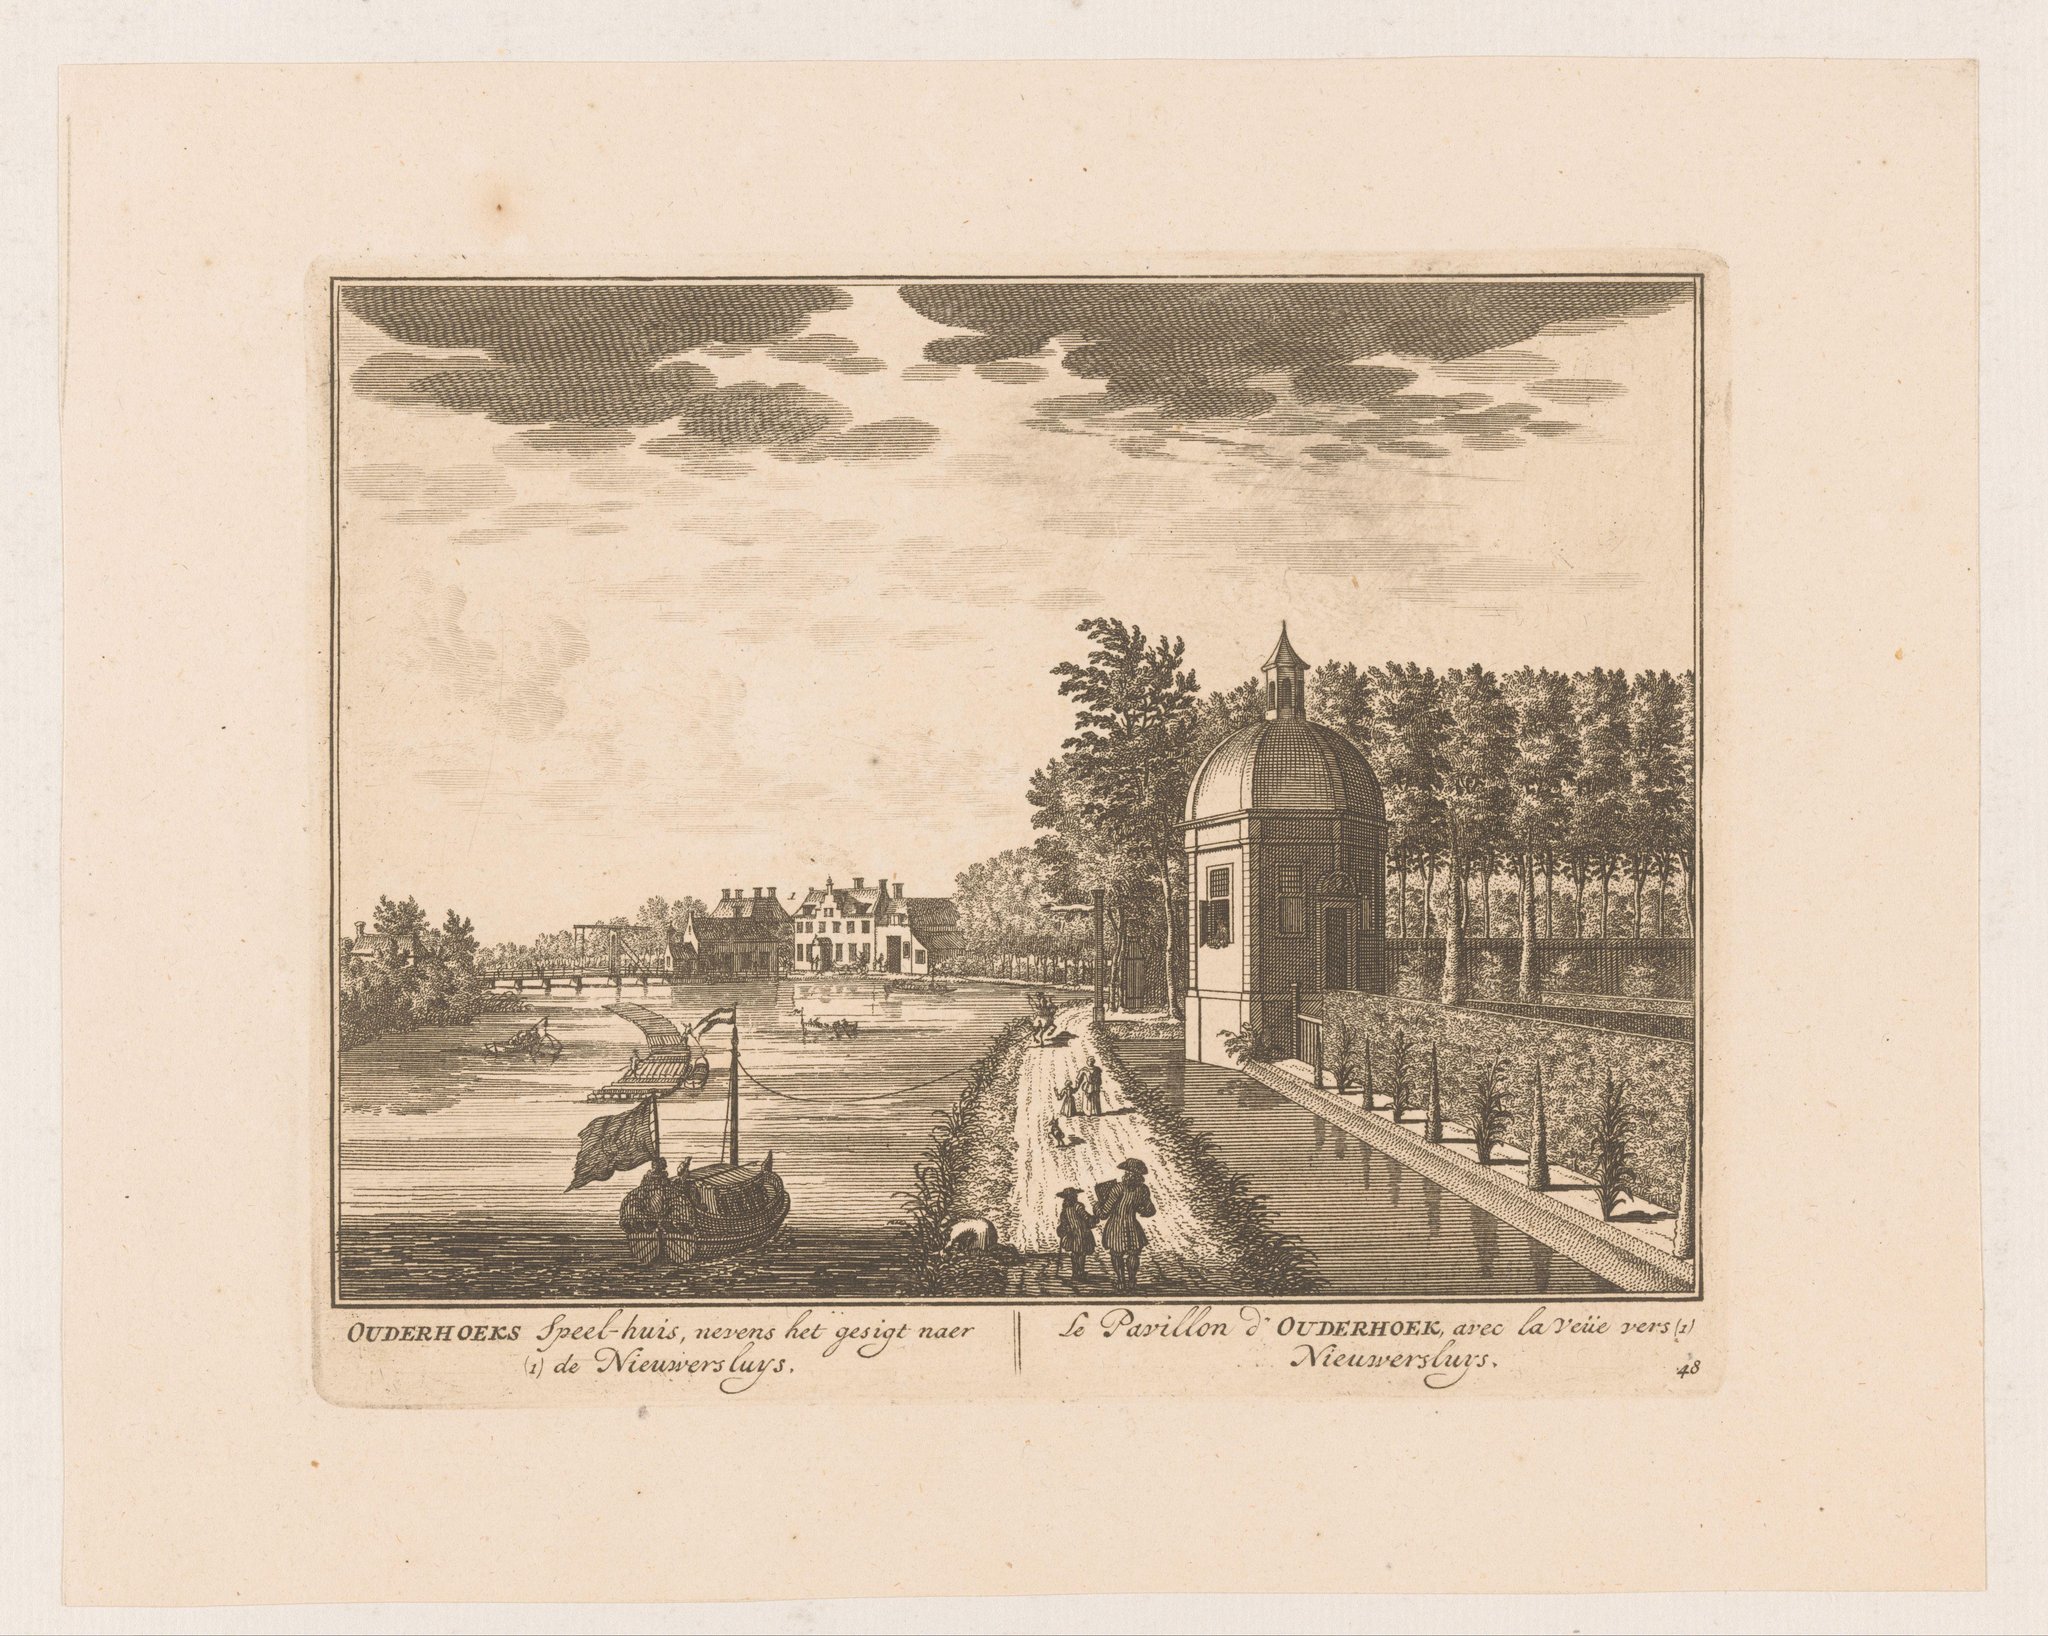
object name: print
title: Paviljoen van Ouderhoek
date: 1719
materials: paper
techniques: etching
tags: river, rural housing, e.g. country-house, villa, cottage, summer-house, arbour, garden-house (dutch: 'theekoepel'), vecht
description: Prent uit: De zegepraalende Vecht, vertoonende verscheidene gesichten van lustplaatsen, heeren huysen en dorpen, beginnende van Uitrecht en met Muyden besluytende. Amsterdam: Wed. Nicolaes Visscher, 1719.